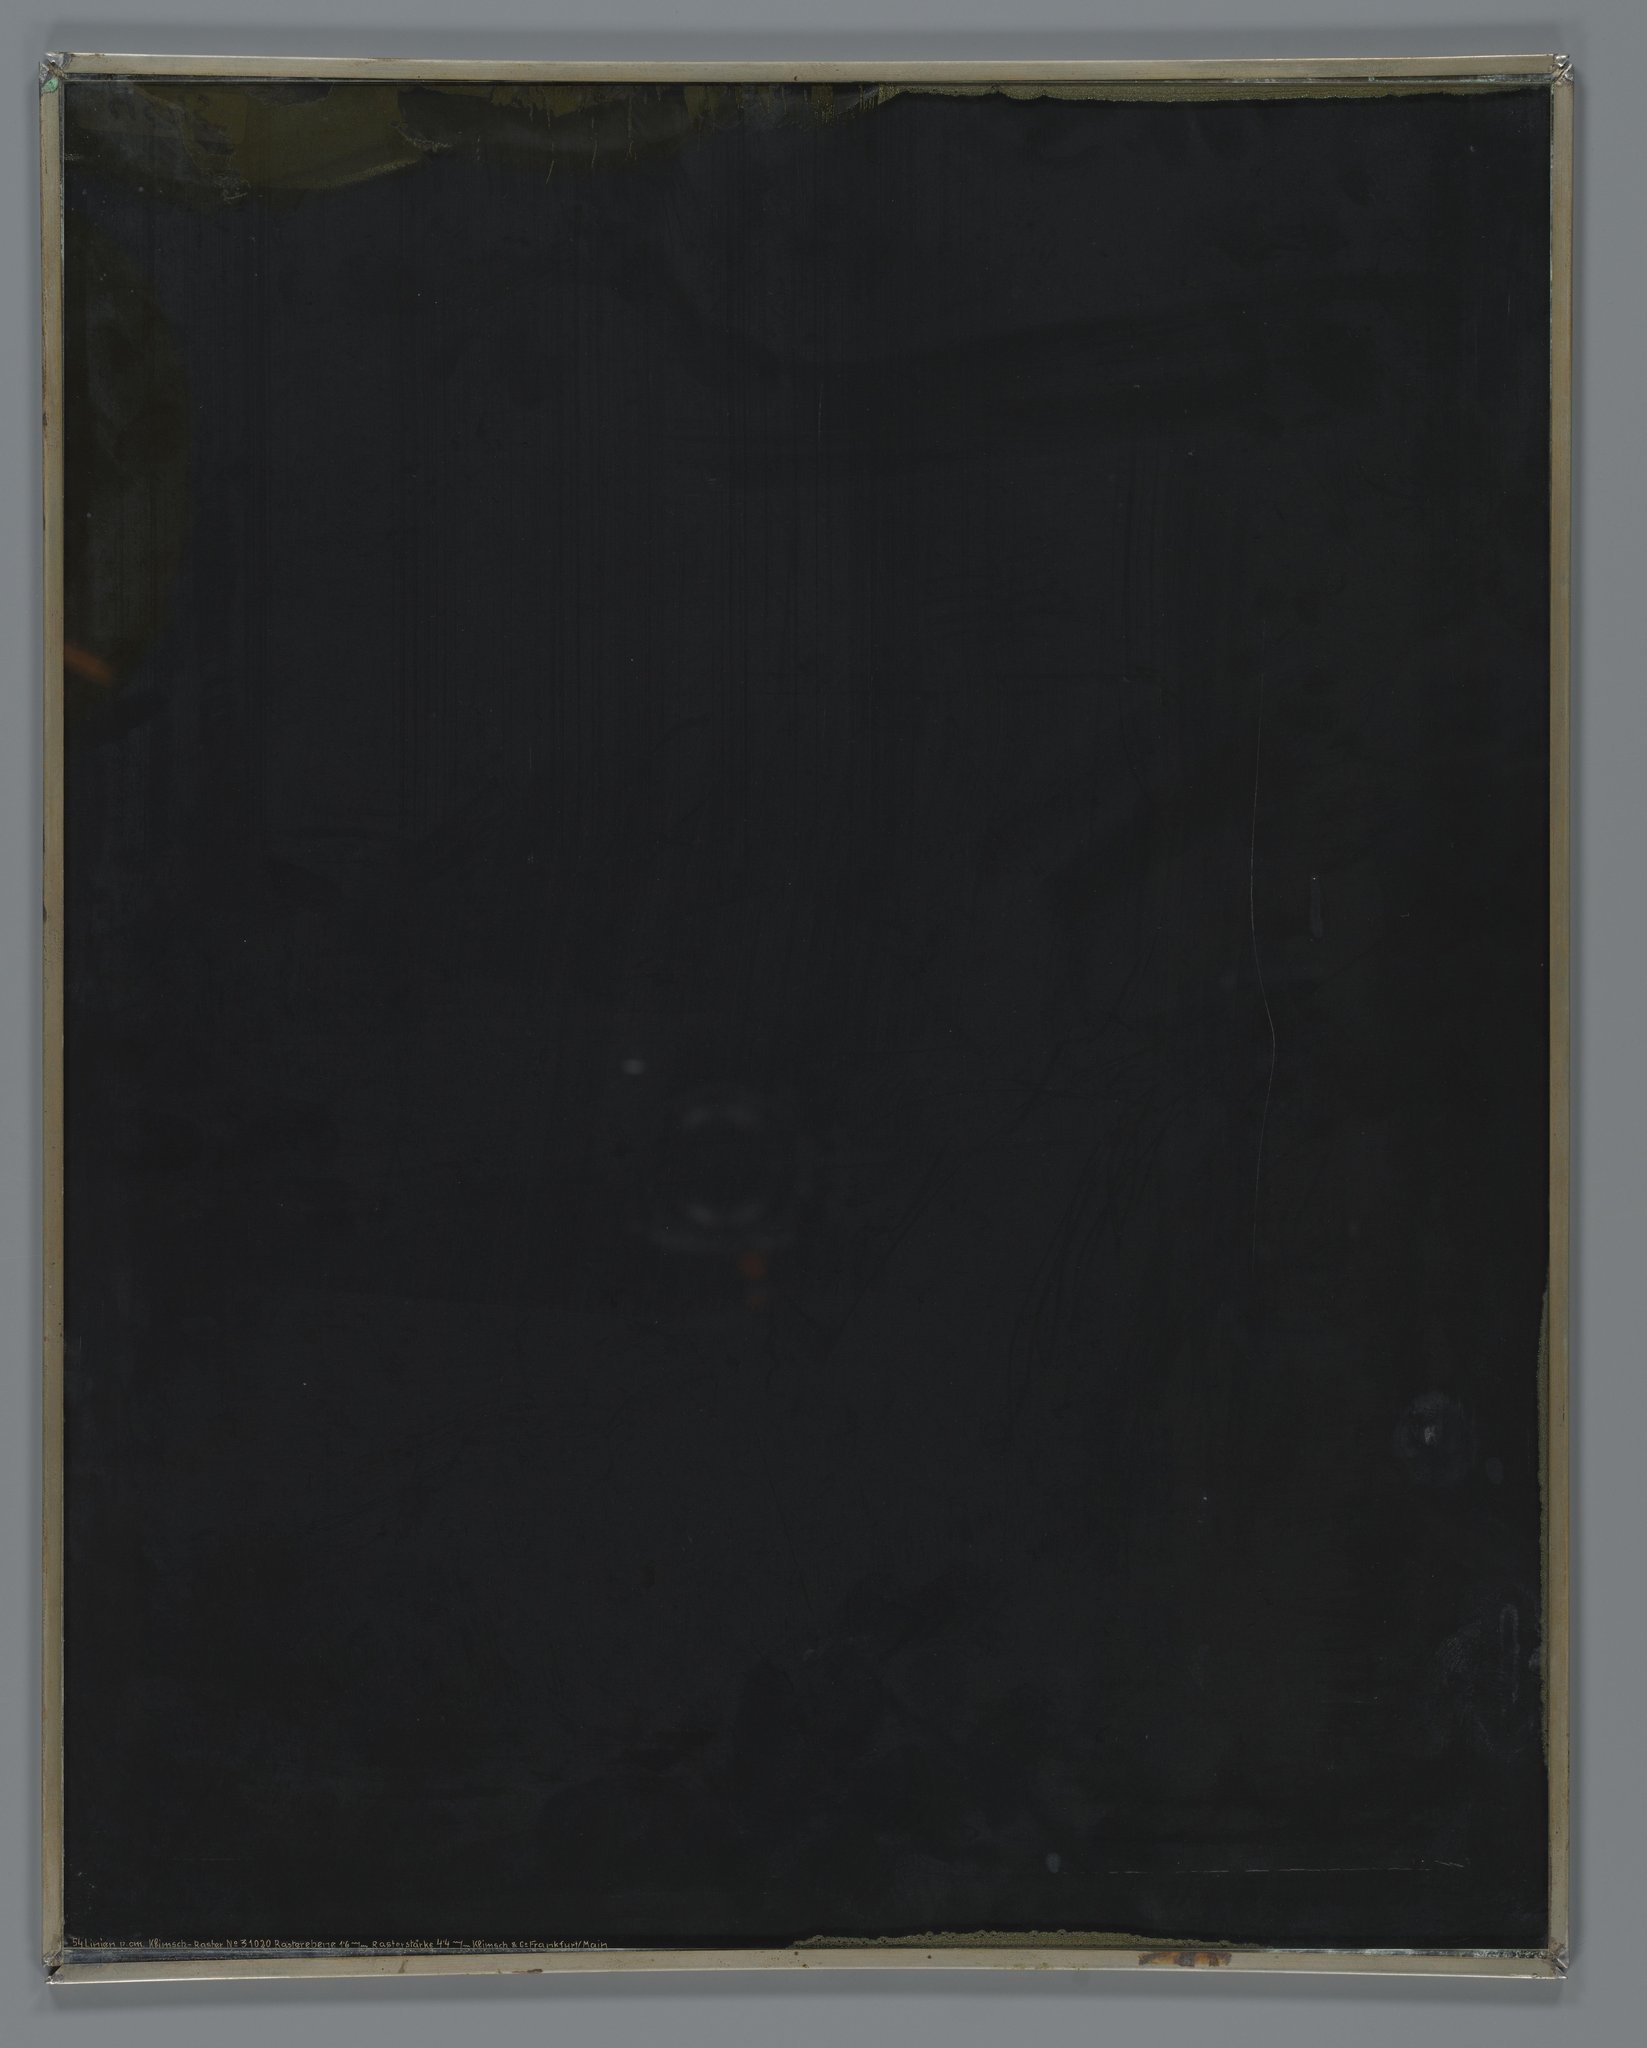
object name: sheet glass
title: Glasplaat voor het maken van autotypieën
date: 1900-1980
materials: glass, metal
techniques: printing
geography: frankfurt am main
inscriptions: inscription: ‘54 Linien p cm. Klimsch-Raster No31020 Rasterebene 1'6 m/m Rasterstärke 4'4 m/m Klimsch & Co. Frankfurt/Main’